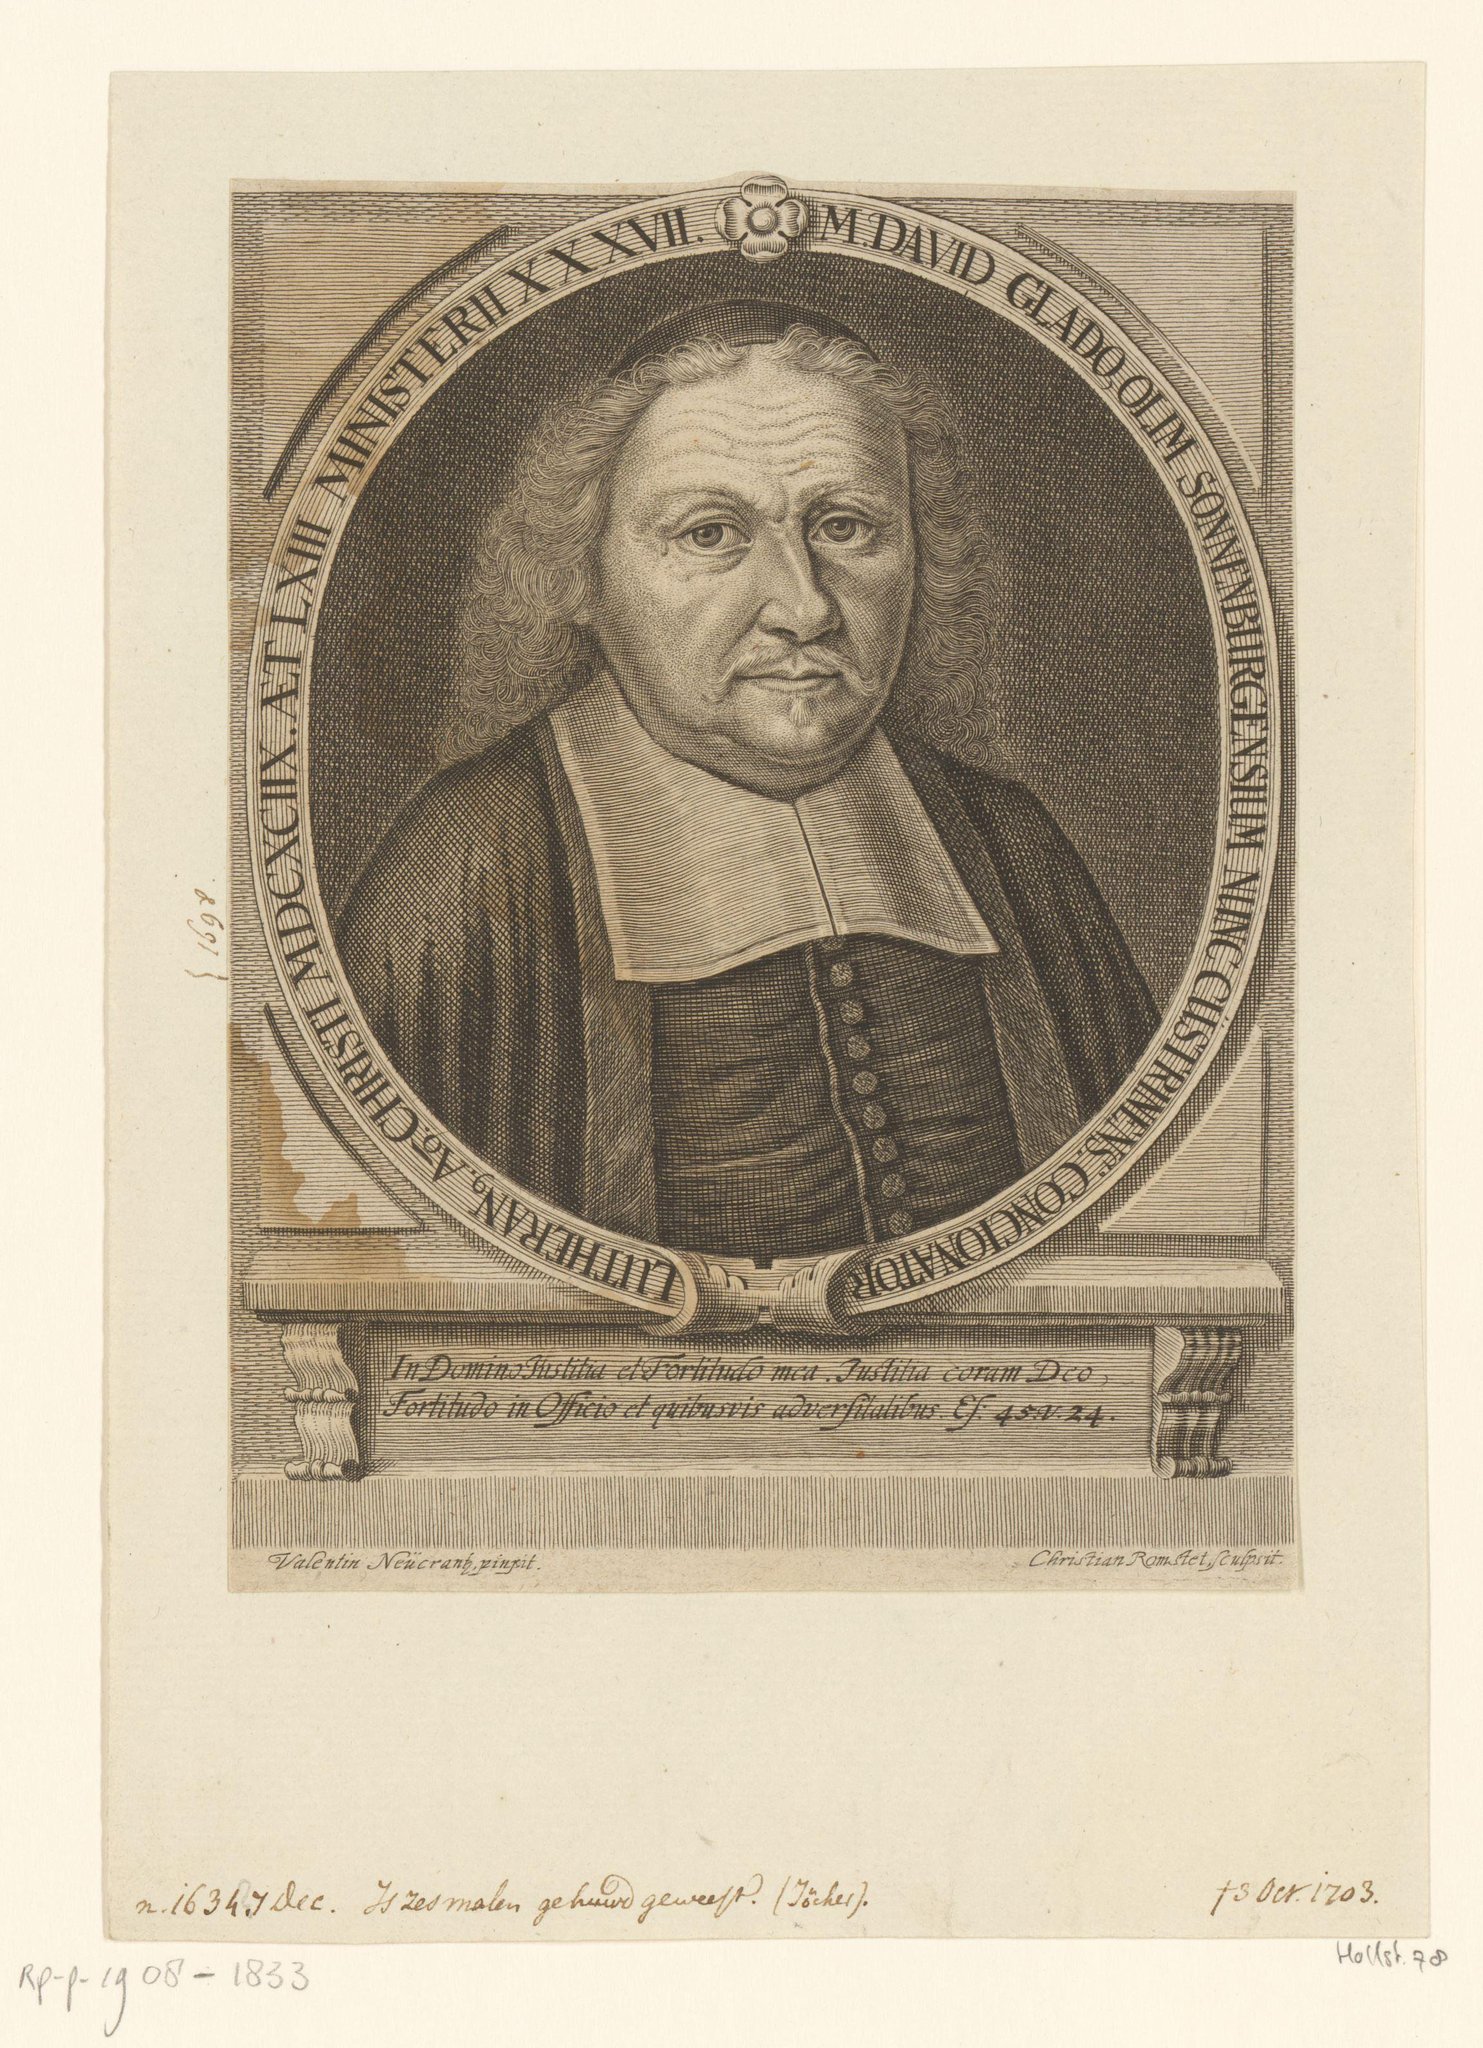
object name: print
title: Portret van David Gladow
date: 1665-1721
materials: paper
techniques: engraving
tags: theologian, historical persons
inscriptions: collector's mark: Lugt 2228